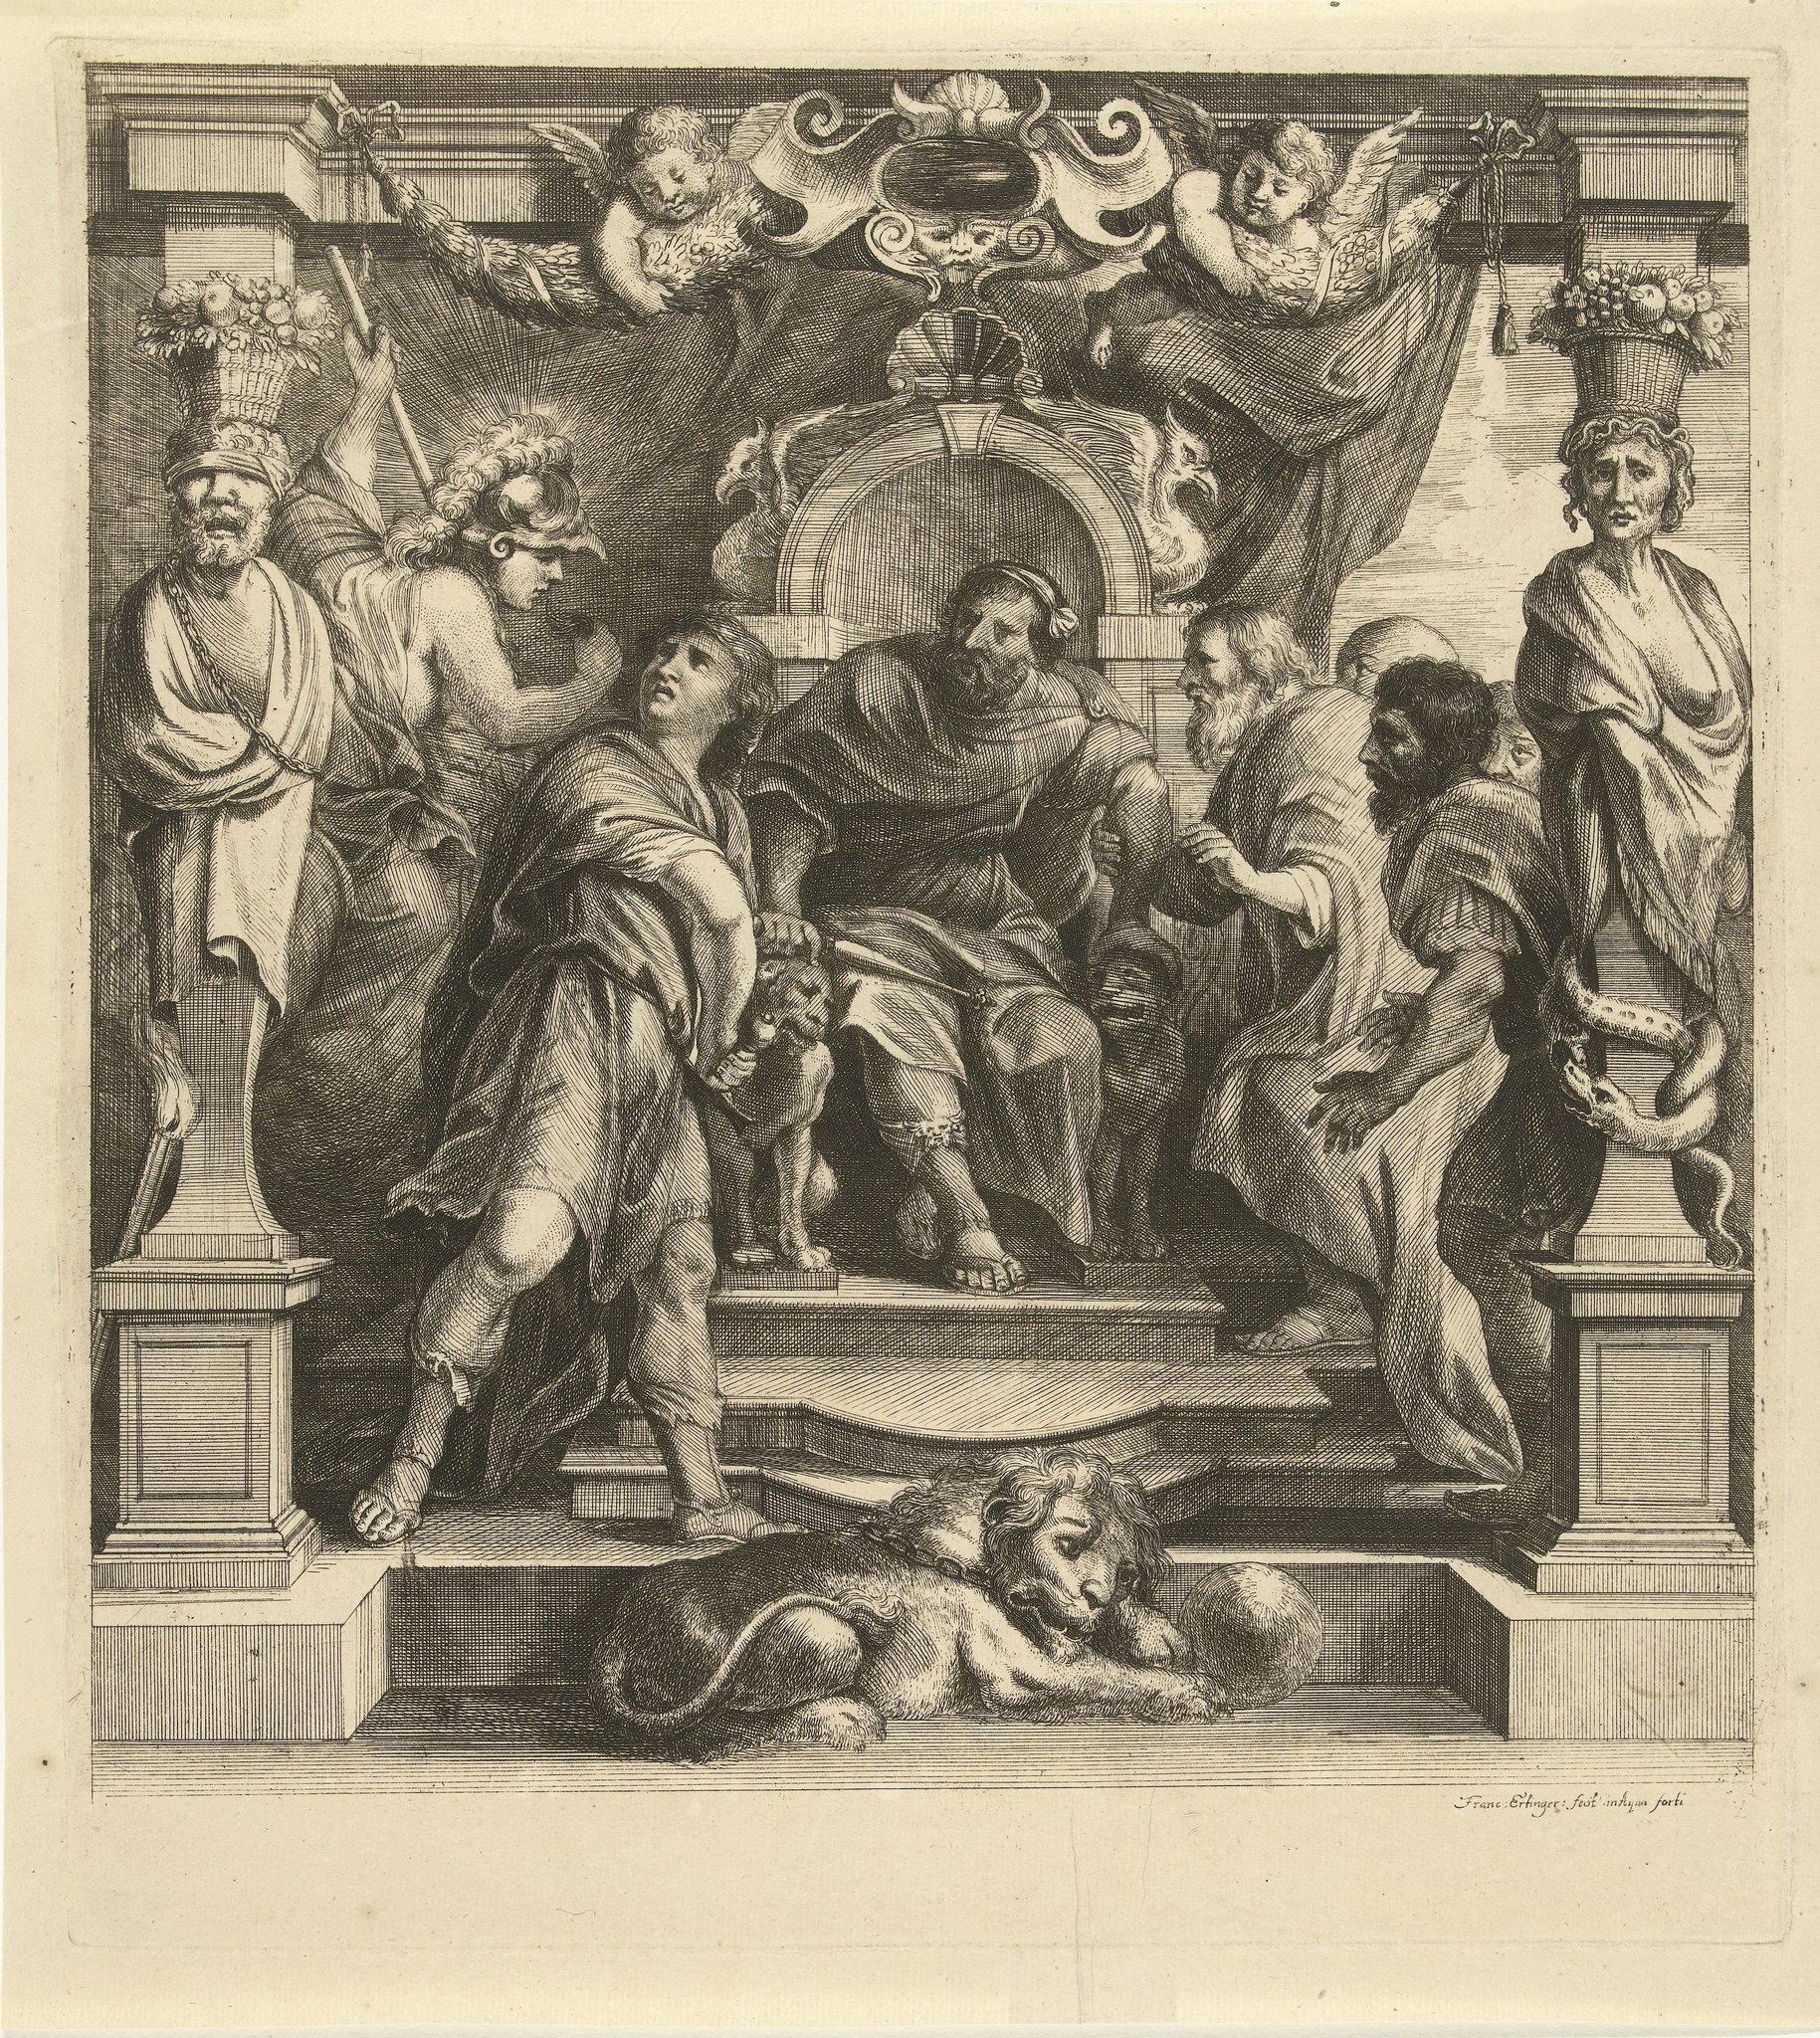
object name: print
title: Twist van Achilles met Agamemnon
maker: franz ertinger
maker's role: print maker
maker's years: 1640-1710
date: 1679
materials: paper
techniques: etching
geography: antwerp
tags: council of the greeks: minerva restrains achilles' anger by seizing him by the hair; possibly nestor trying to calm agamemnon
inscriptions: collector's mark: Lugt 240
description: Achilles staat op het punt zijn zwaard te trekken om Agamemnon, zittend op zijn troon, te doden. Hij kijkt op naar Pallas Athene, die hem van de moord weerhoudt.